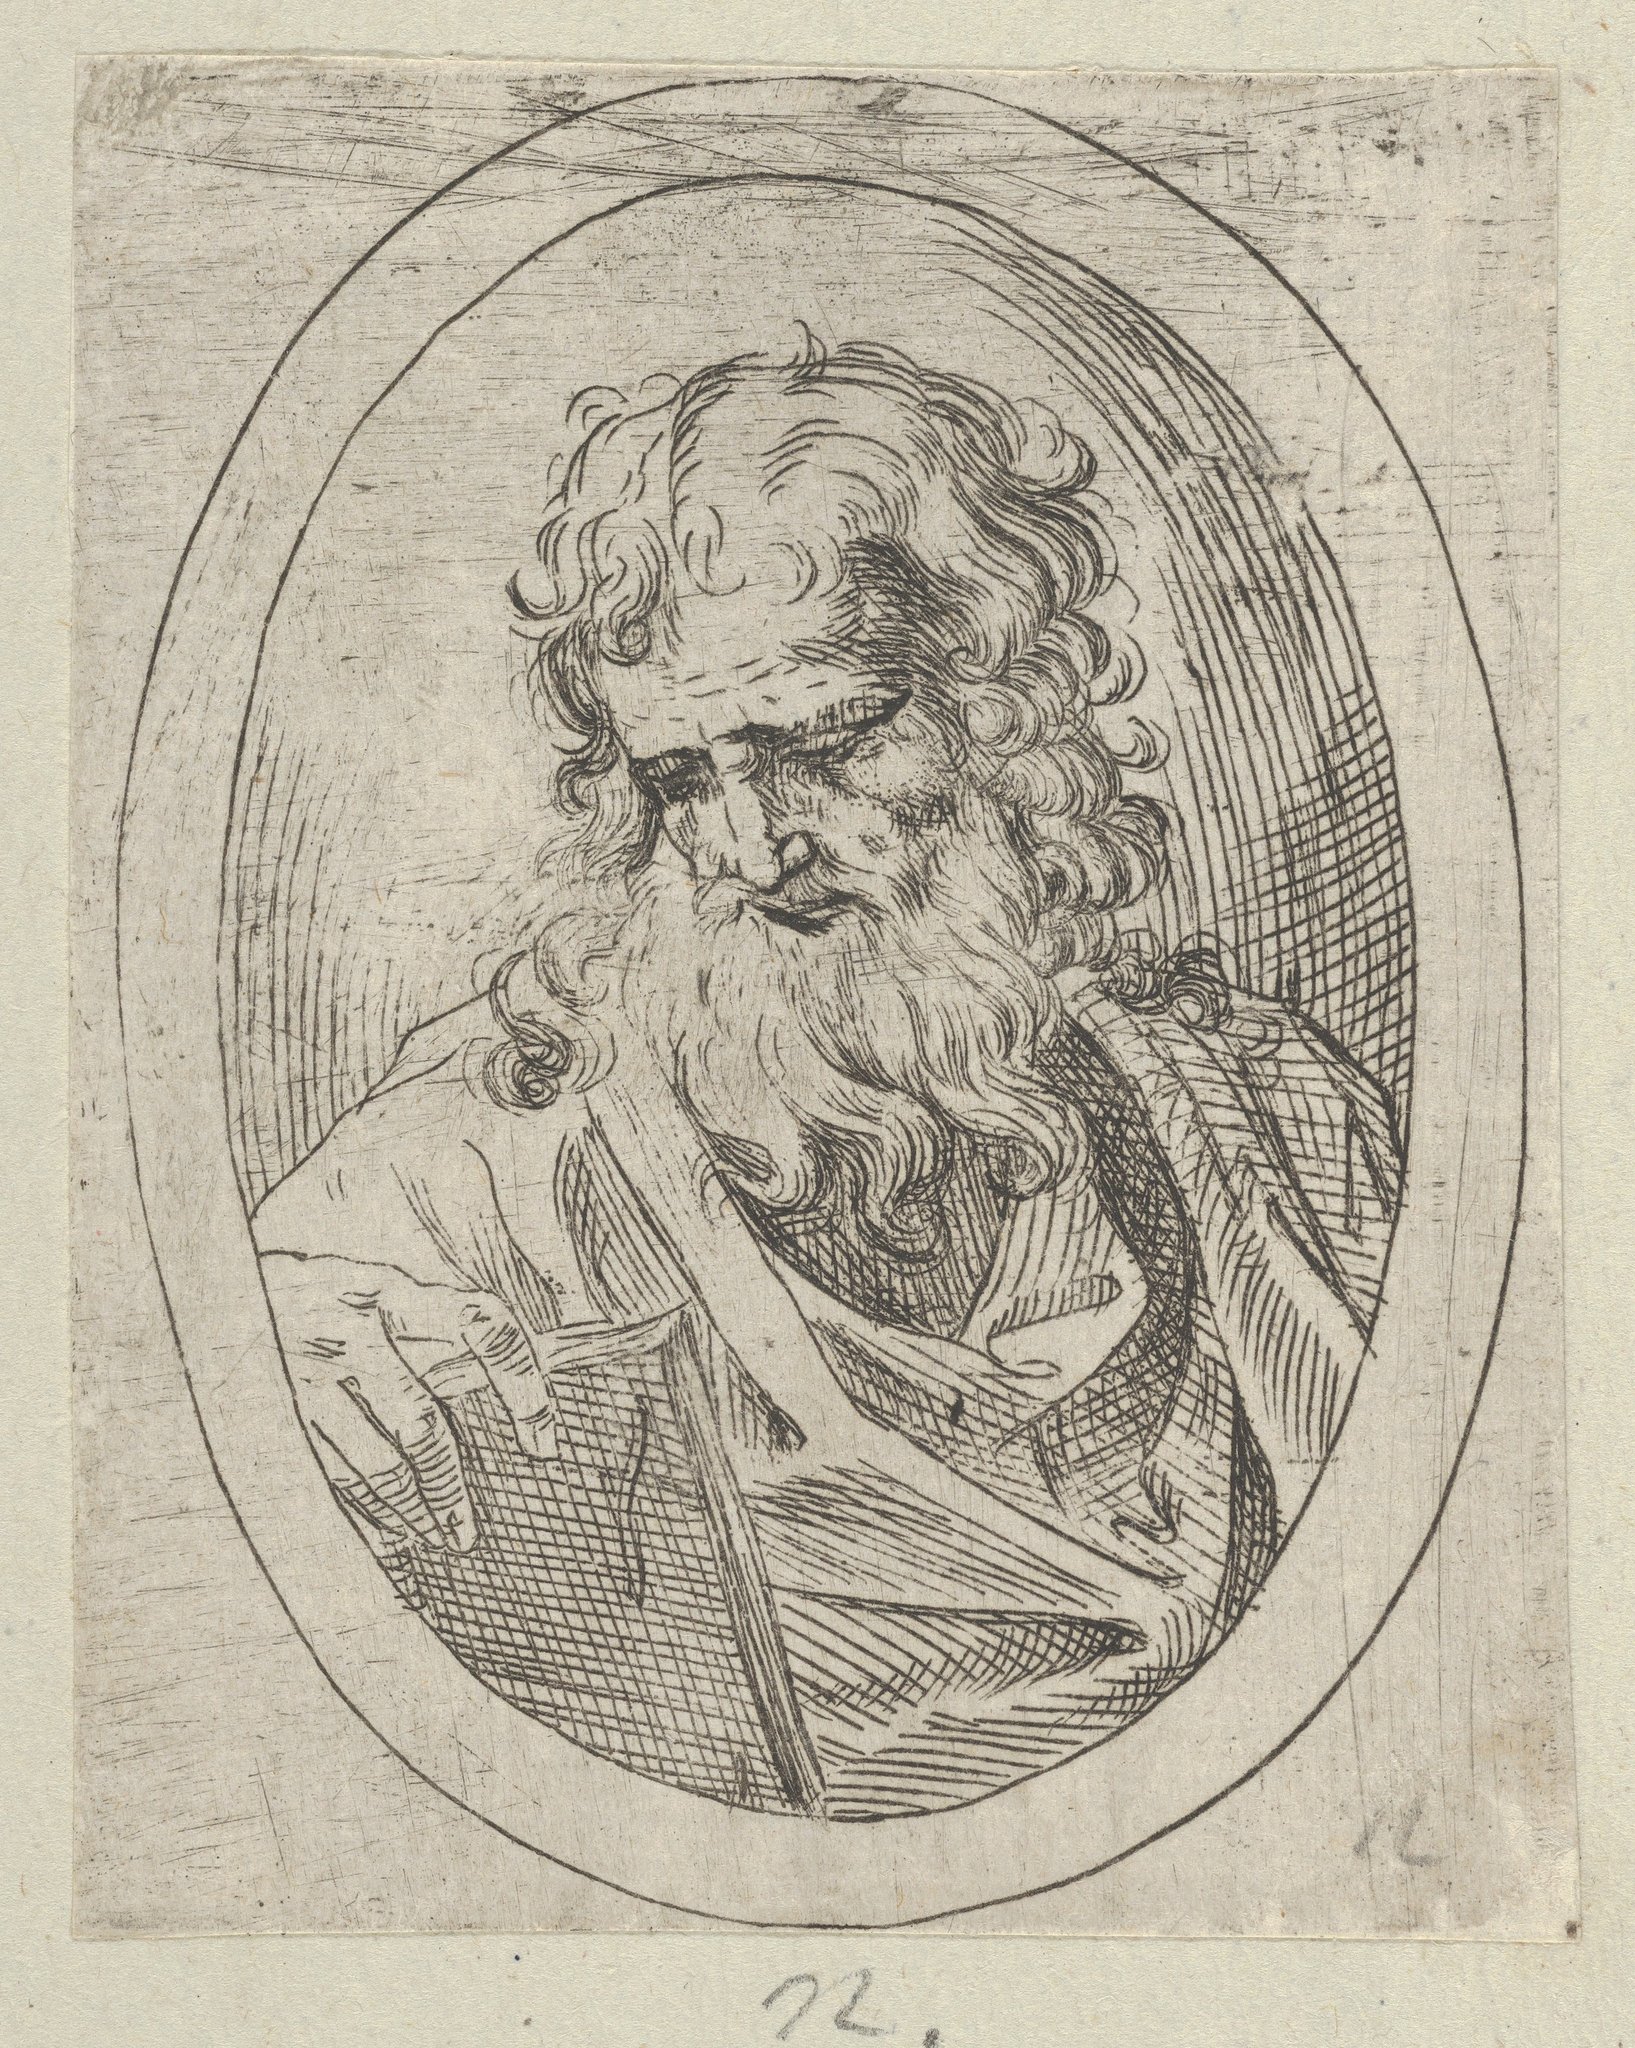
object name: print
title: An apostle with a long beard looking down at an open book, in an oval frame, from "Christ, the Virgin, and Thirteen Apostles"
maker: anonymous, 17th century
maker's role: artist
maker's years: 1600-1700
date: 1600-1640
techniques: etching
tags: apostles